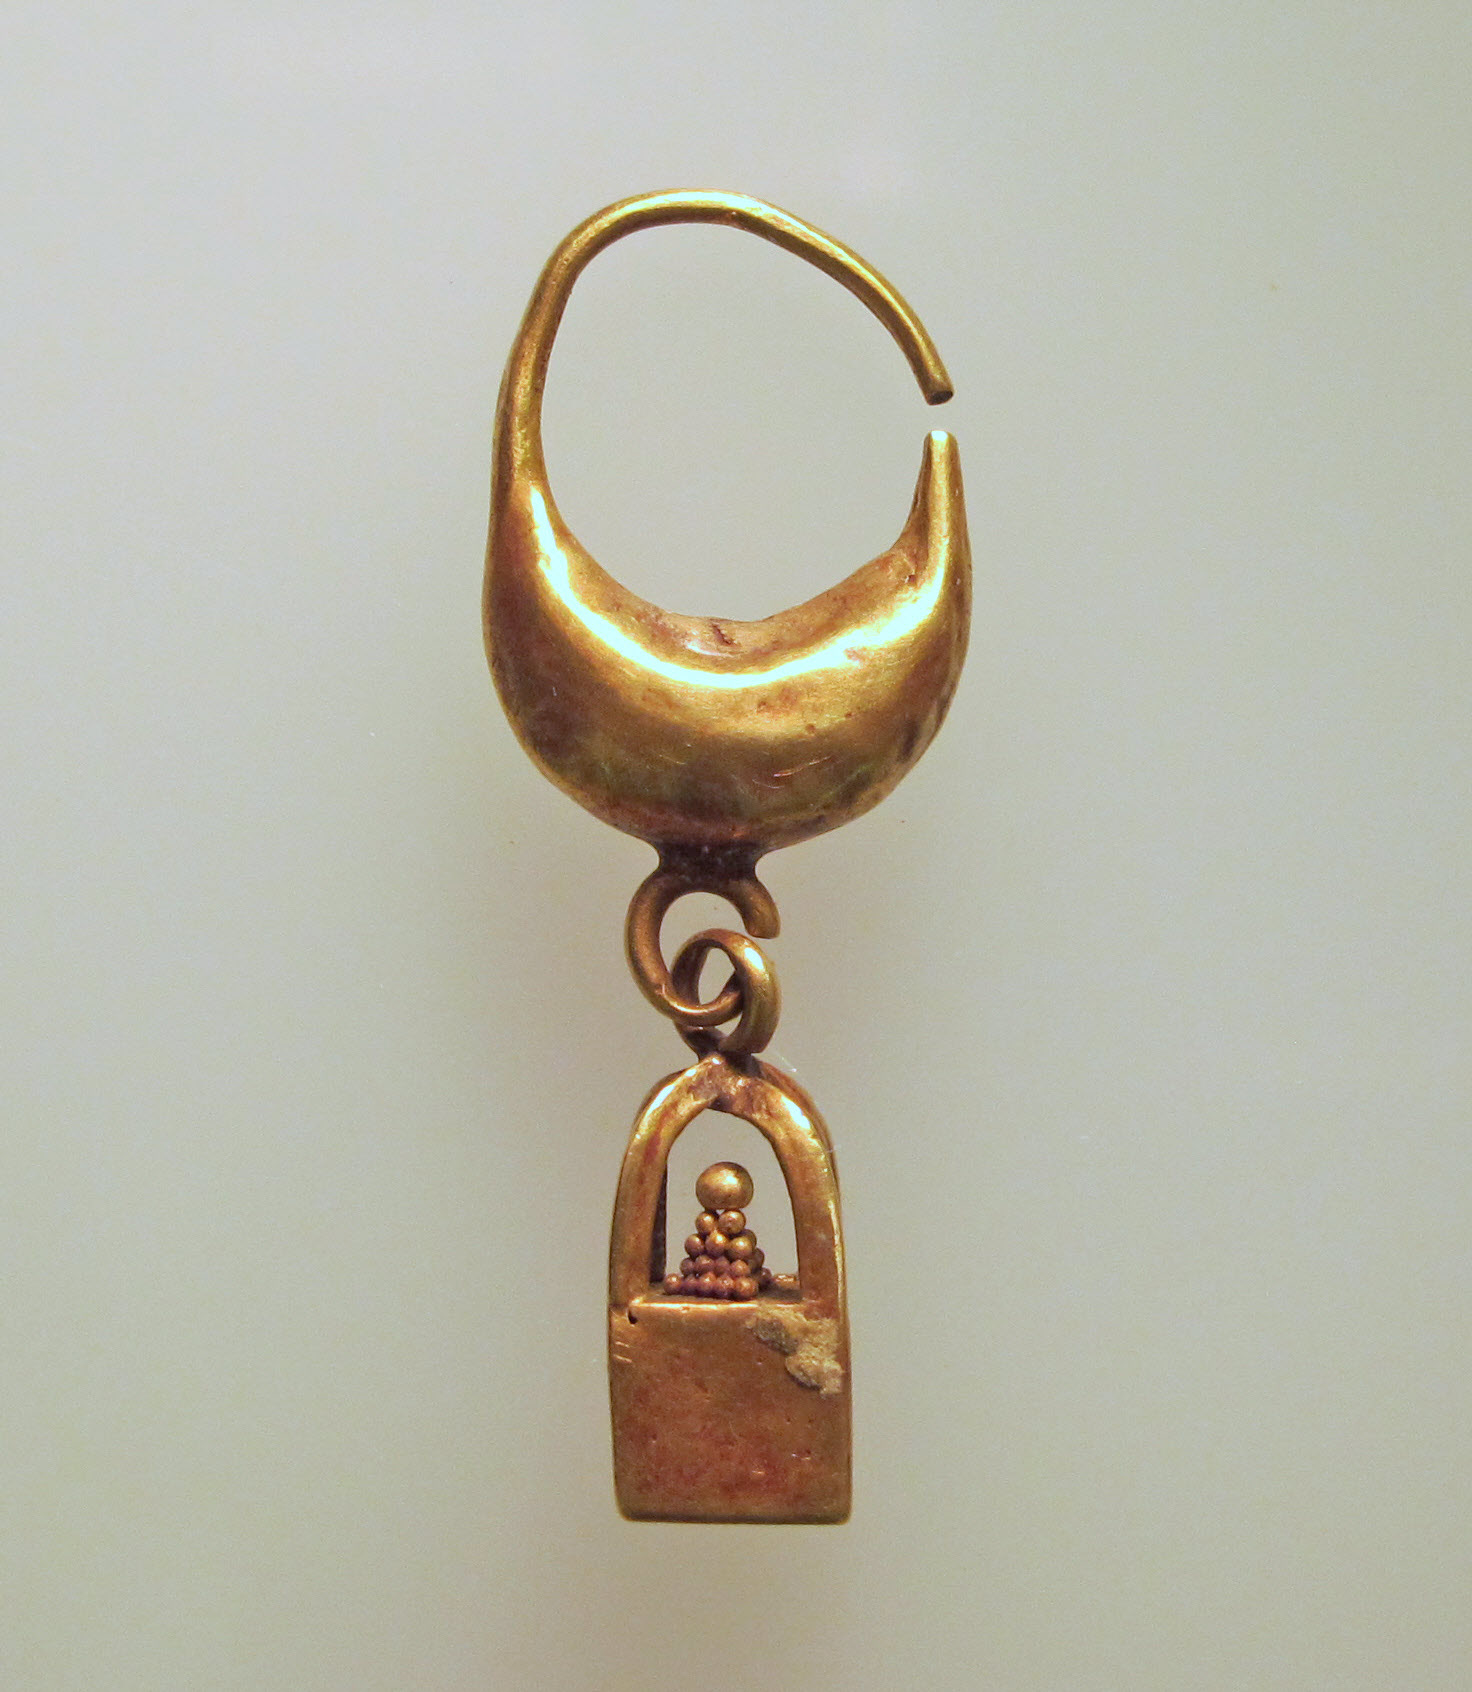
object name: earring, boat shaped with cage and ball pendant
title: Earring, boat-shaped with cage and ball pendant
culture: cypriot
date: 3900 BCE-100 CE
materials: gold